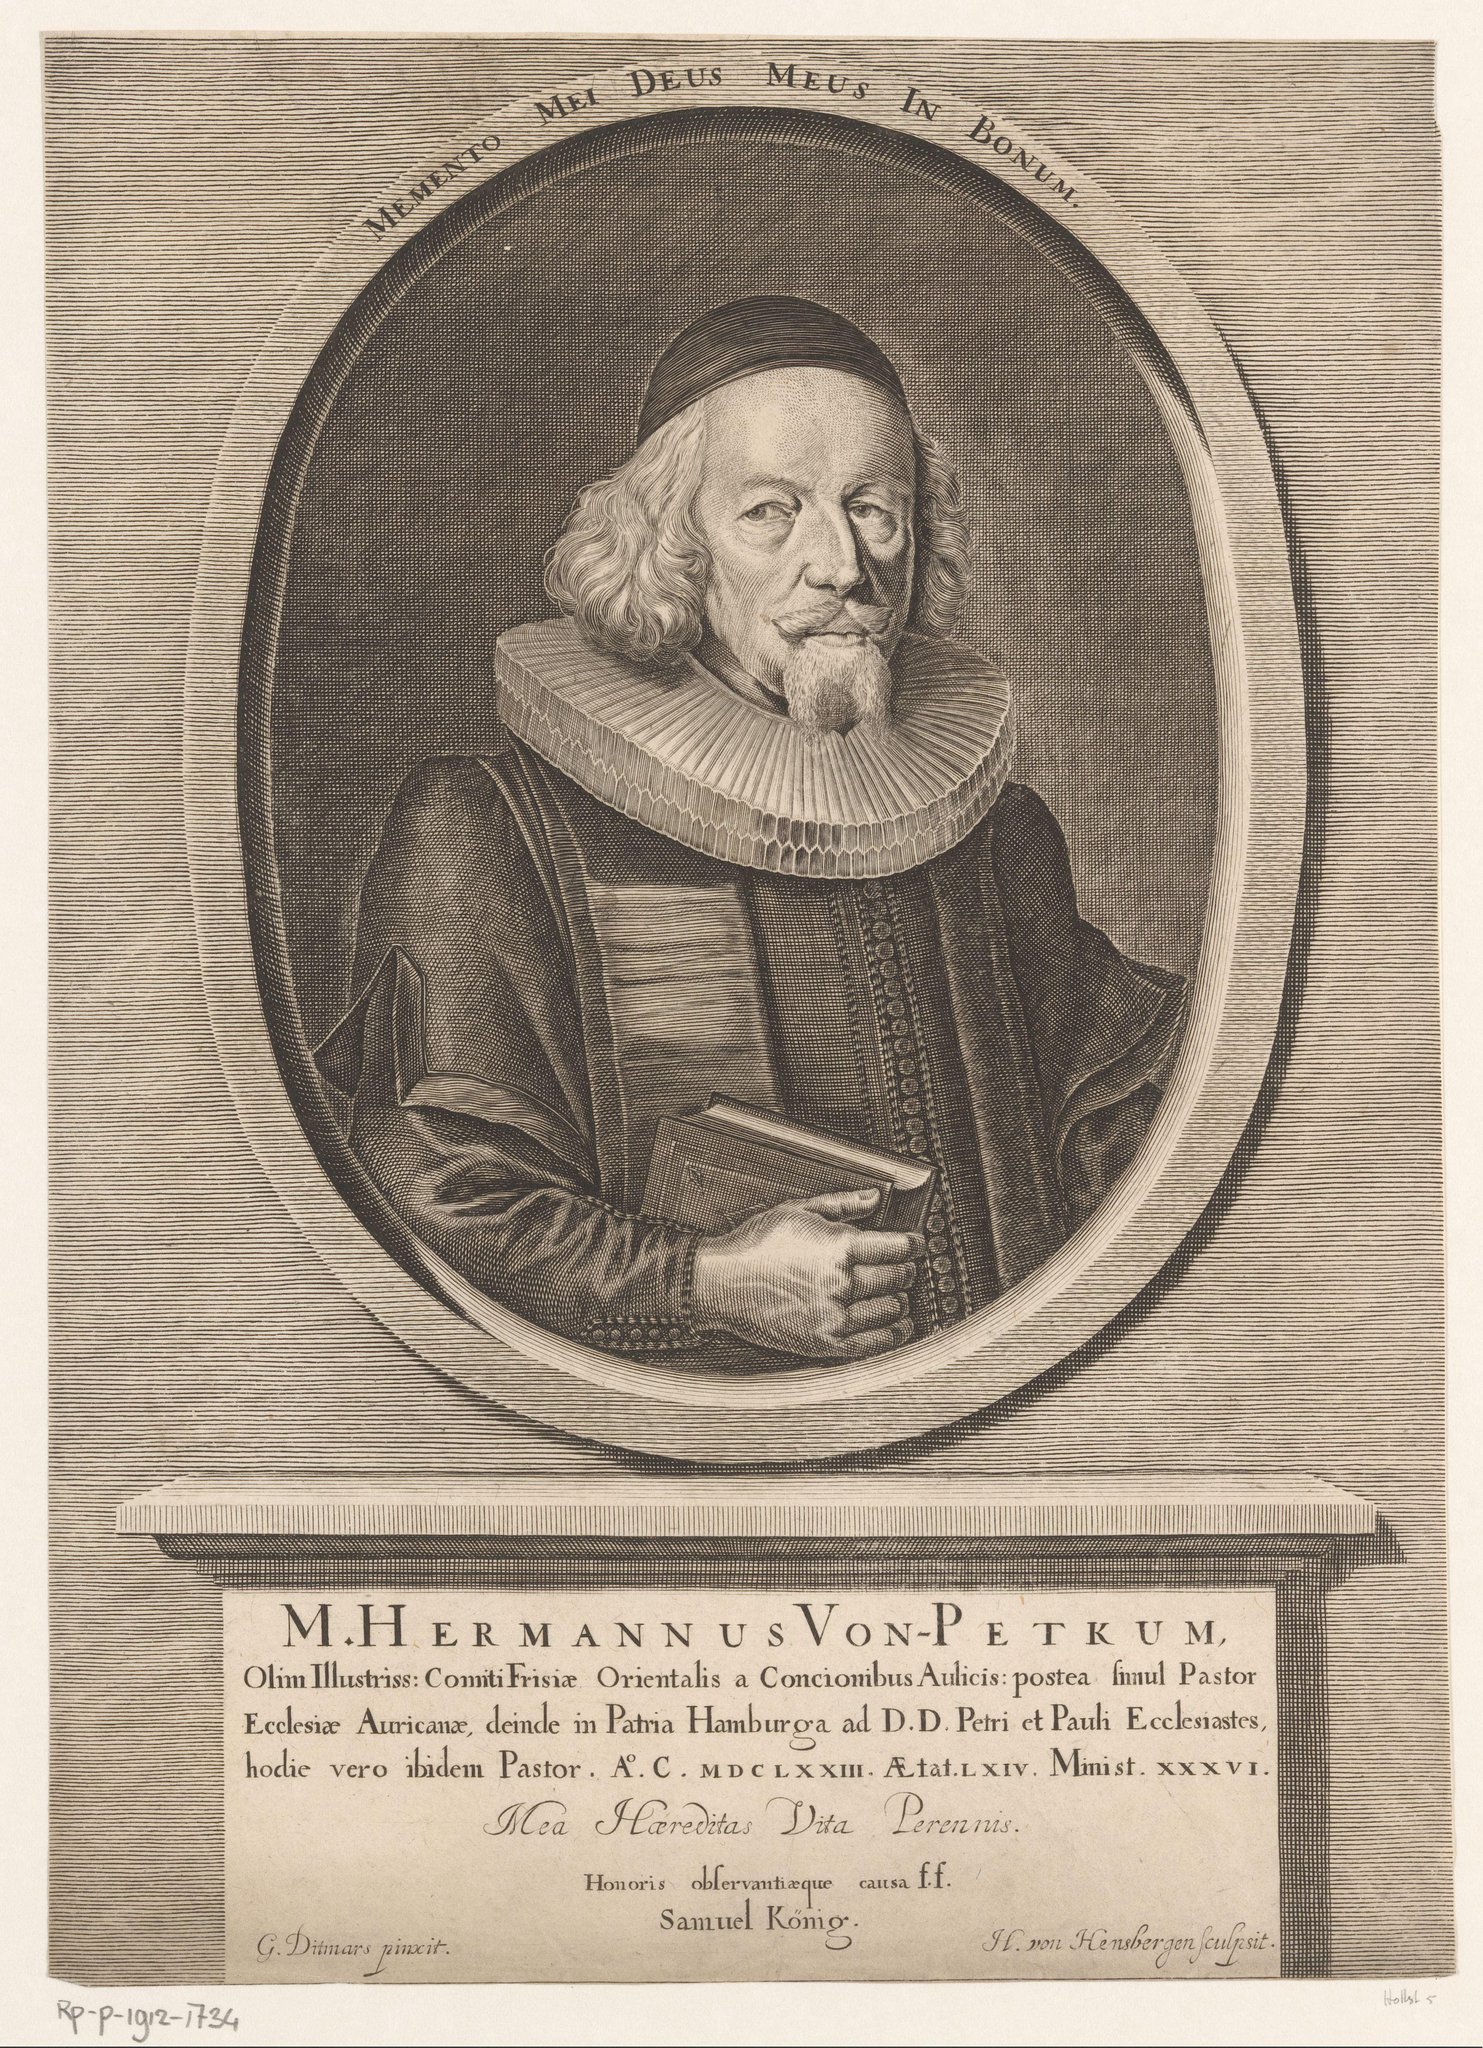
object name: print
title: Portret van Hermann von Petkum op 64-jarige leeftijd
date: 1674-1682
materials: paper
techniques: engraving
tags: historical persons, book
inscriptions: collector's mark: Lugt 2228